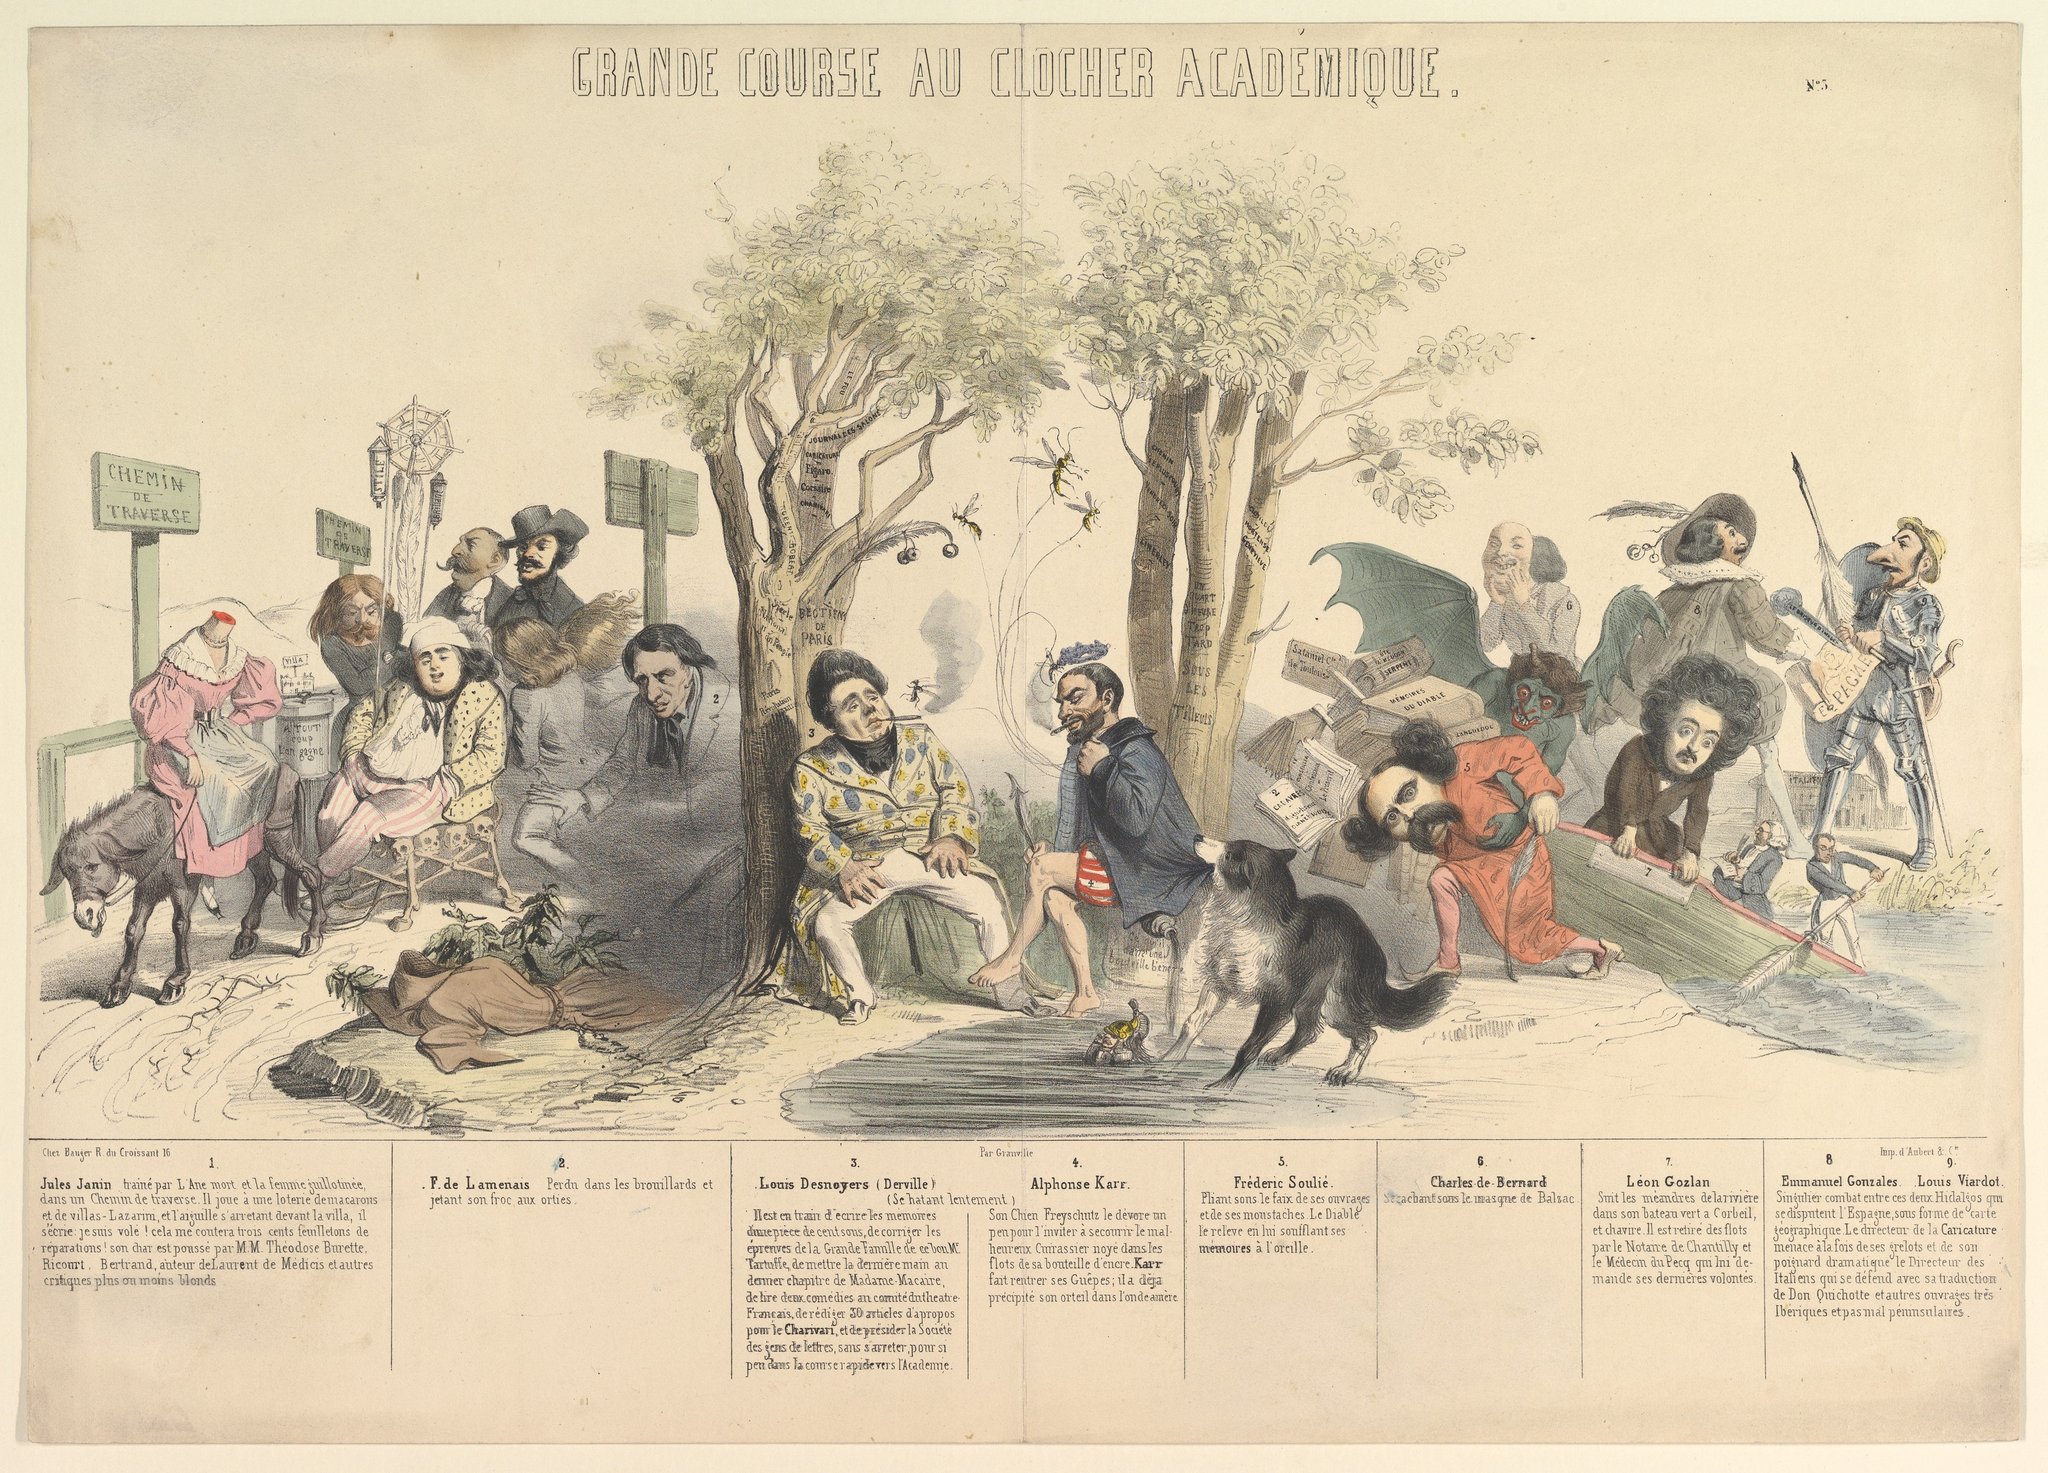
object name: print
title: Grand Course au Clocher Académique, No. 5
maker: j. j. grandville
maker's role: artist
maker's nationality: french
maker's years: 1803-1847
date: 1844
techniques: hand coloring, lithograph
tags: satire,men,dogs,donkeys